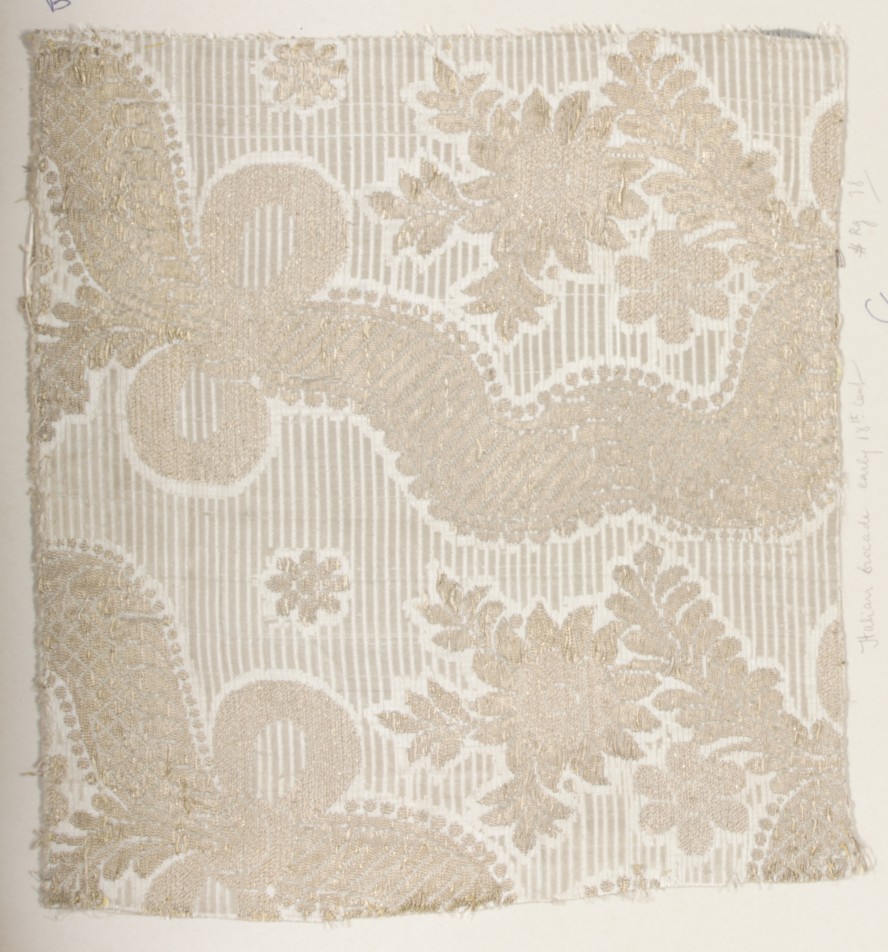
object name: fragment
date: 1701-1800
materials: metal thread, silk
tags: flowers,leaves